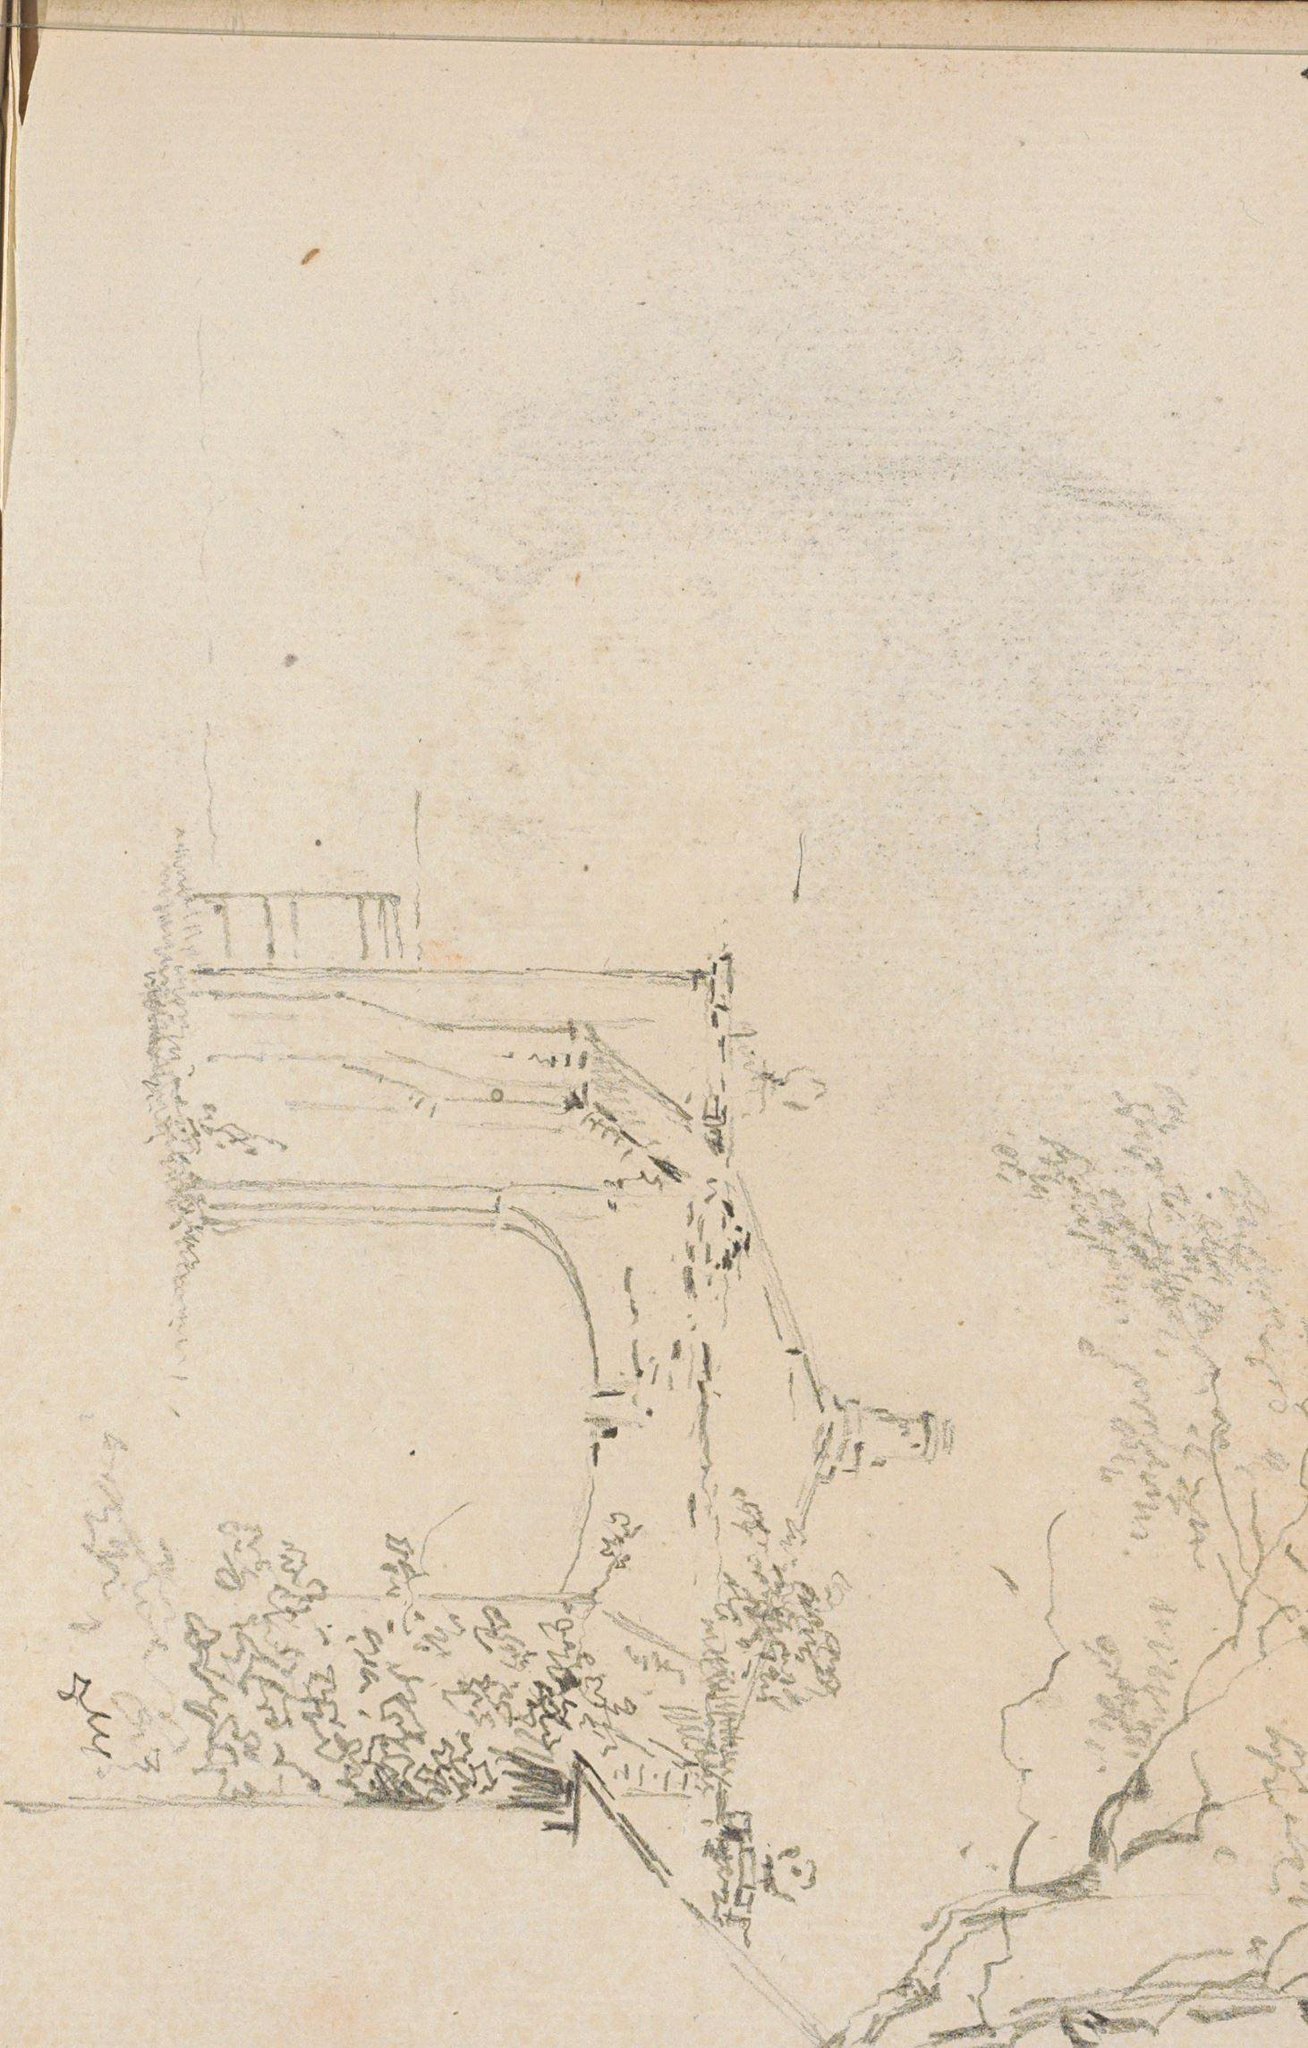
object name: sketchbook leaf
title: Overgroeide poort bij een boom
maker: jacob perkois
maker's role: draughtsman, print maker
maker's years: 1756-1804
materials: paper, pencil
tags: gate, entrance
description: Bladzijde 27 uit een schetsboek met 78 bladzijden.